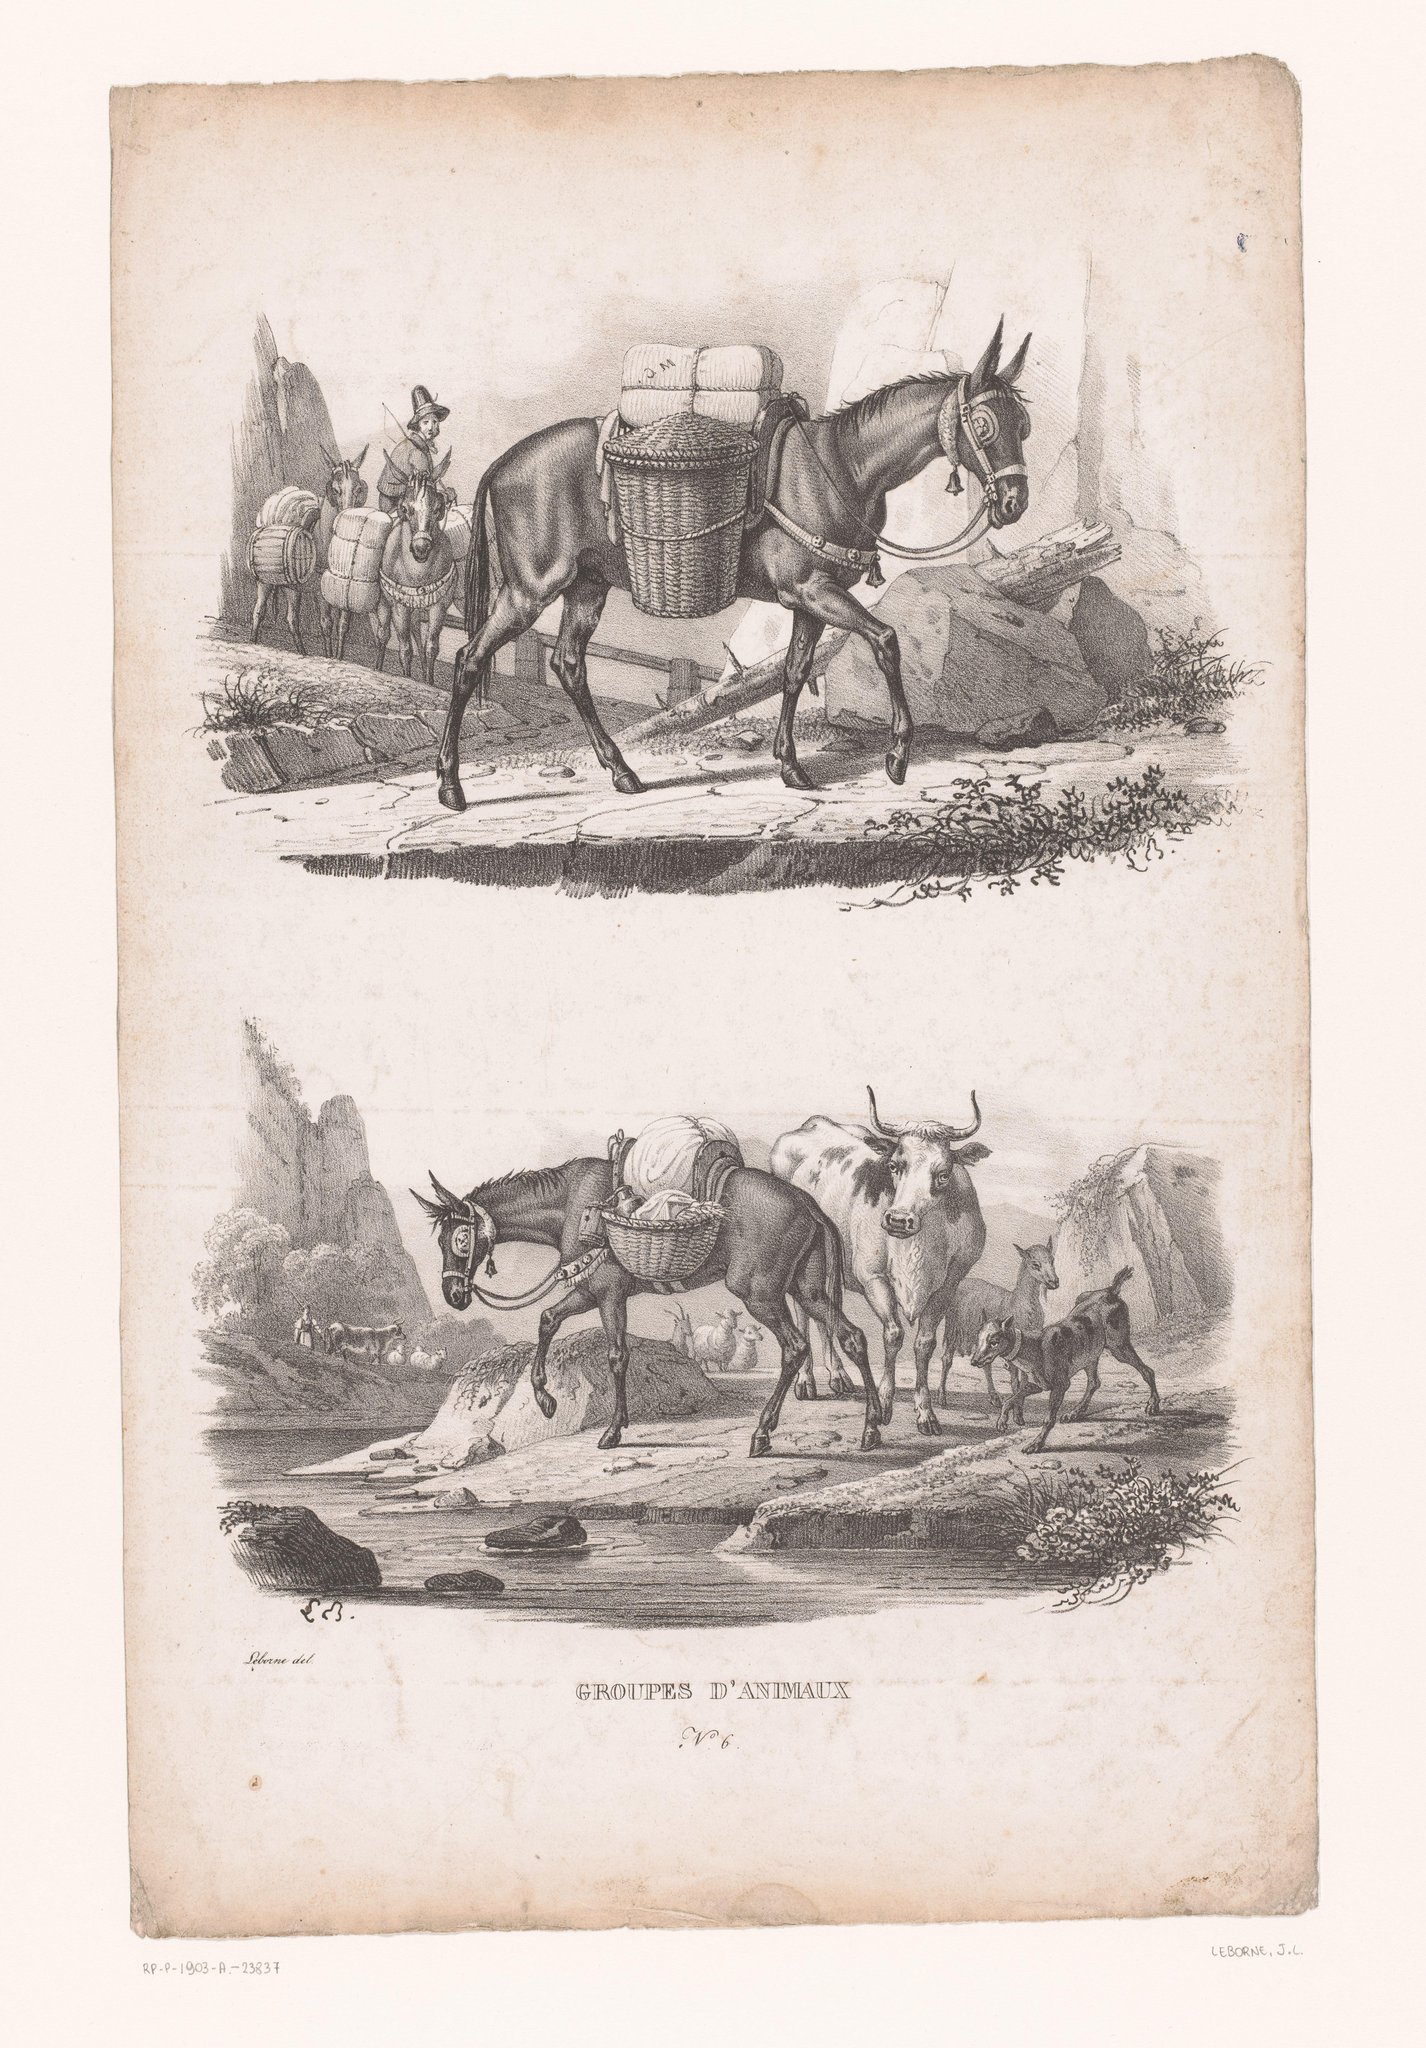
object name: print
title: Muilezel en dieren bij een drinkplaats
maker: joseph louis leborne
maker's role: painter, print maker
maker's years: 1796-1865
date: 1828-1829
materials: paper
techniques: lithograph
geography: paris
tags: giving water, feeding (cattle), mule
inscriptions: collector's mark: Lugt 2228a